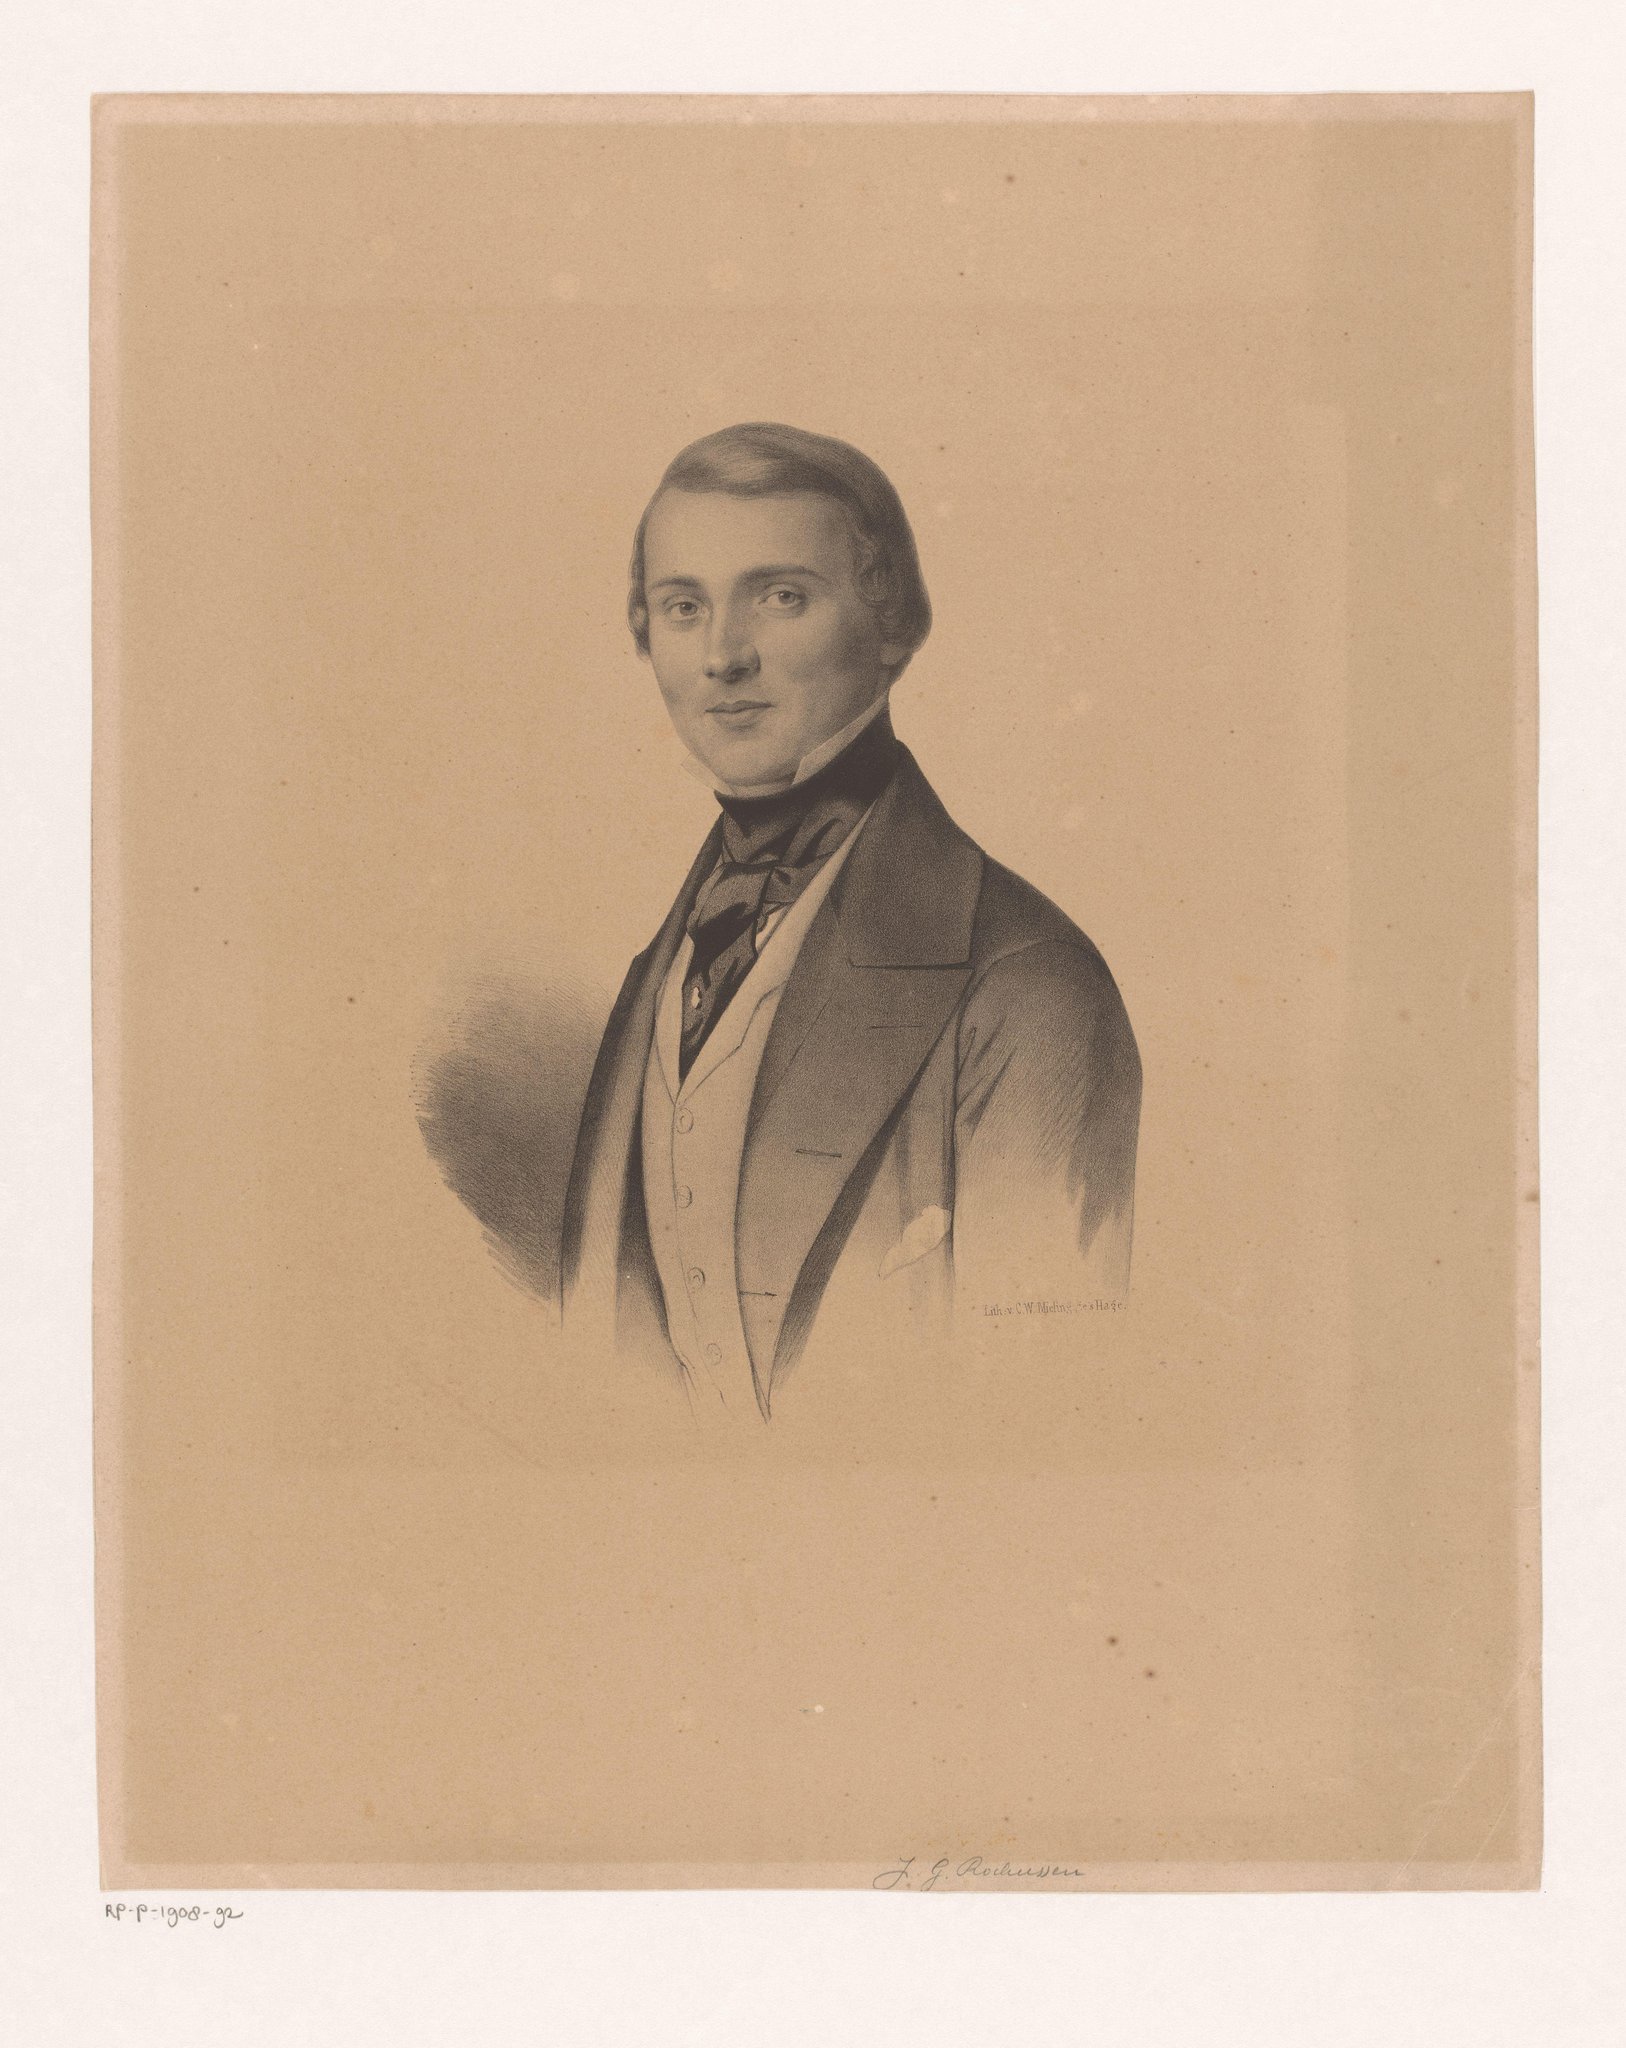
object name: print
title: Portret van een onbekende man, mogelijk J. G. Rochussen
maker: Anonymous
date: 1845-1847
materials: paper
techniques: lithograph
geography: the hague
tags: historical persons (+ (full) bust portrait)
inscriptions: collector's mark: Lugt 2228, inscription: ‘J. G. Rochussen’